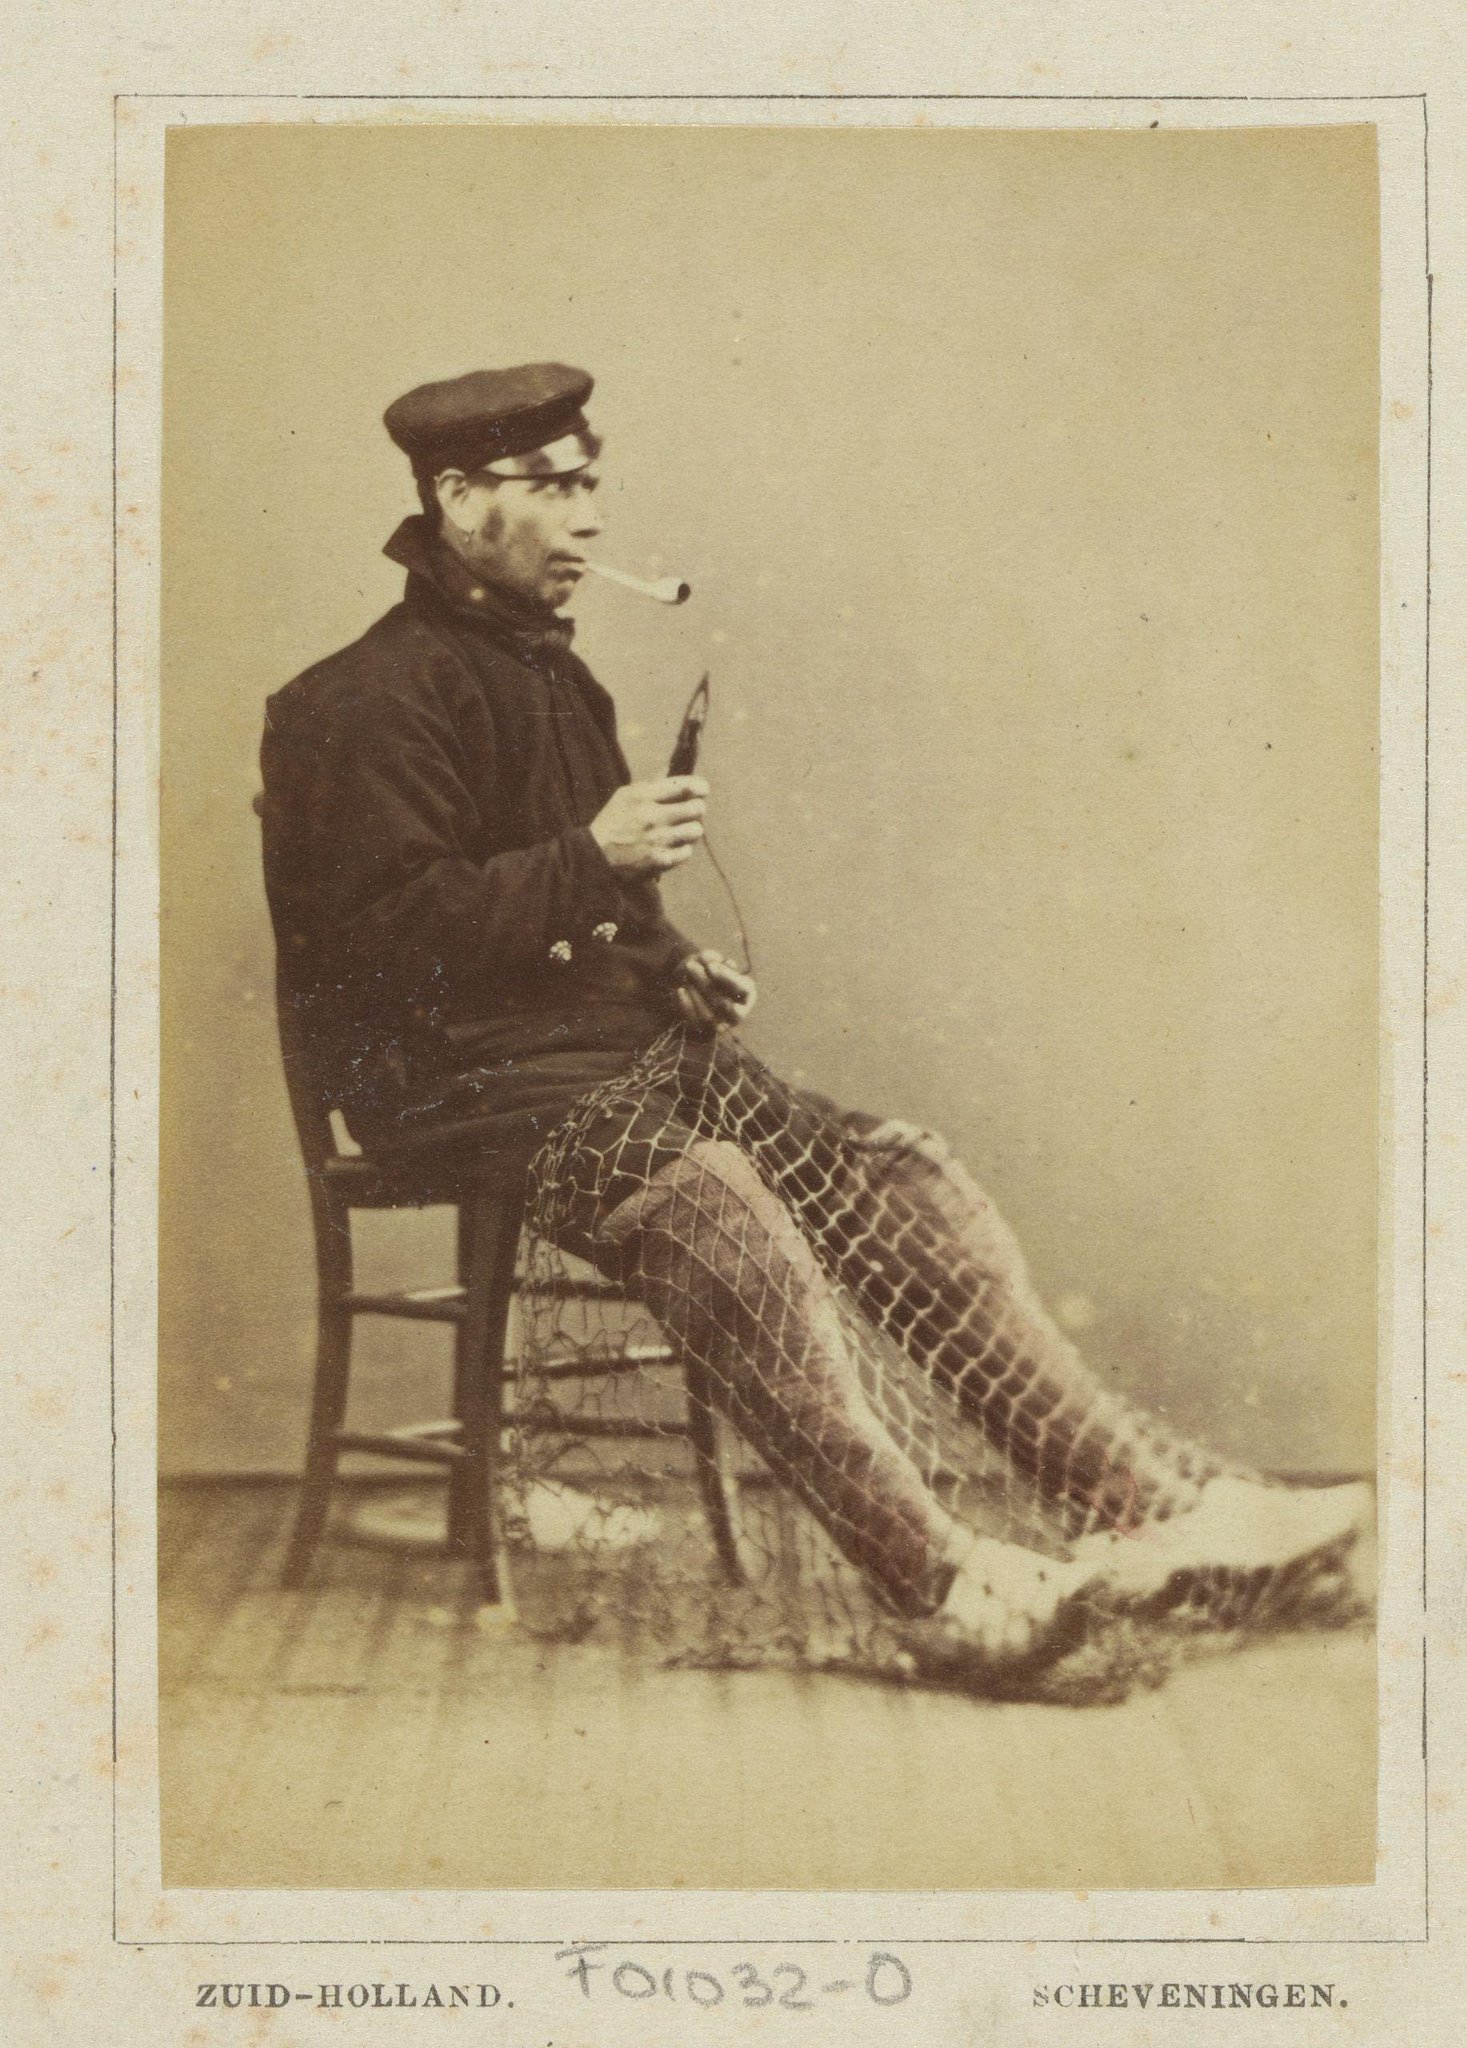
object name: photograph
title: La Hollande Méridionale. Scheveningue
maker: andries jager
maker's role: publisher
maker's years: 1825-1905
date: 1860-1890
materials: cardboard, photographic support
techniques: albumen print, hand coloring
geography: amsterdam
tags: folk costume, regional costume (+ men's clothes), europeans (with name), fisherman, netherlands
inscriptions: inscription: ‘Uitgave van A. JAGER, Water 110 te Amsterdam.’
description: Deze foto maakt deel uit van een omslag met 48 foto's op 12 bladen.